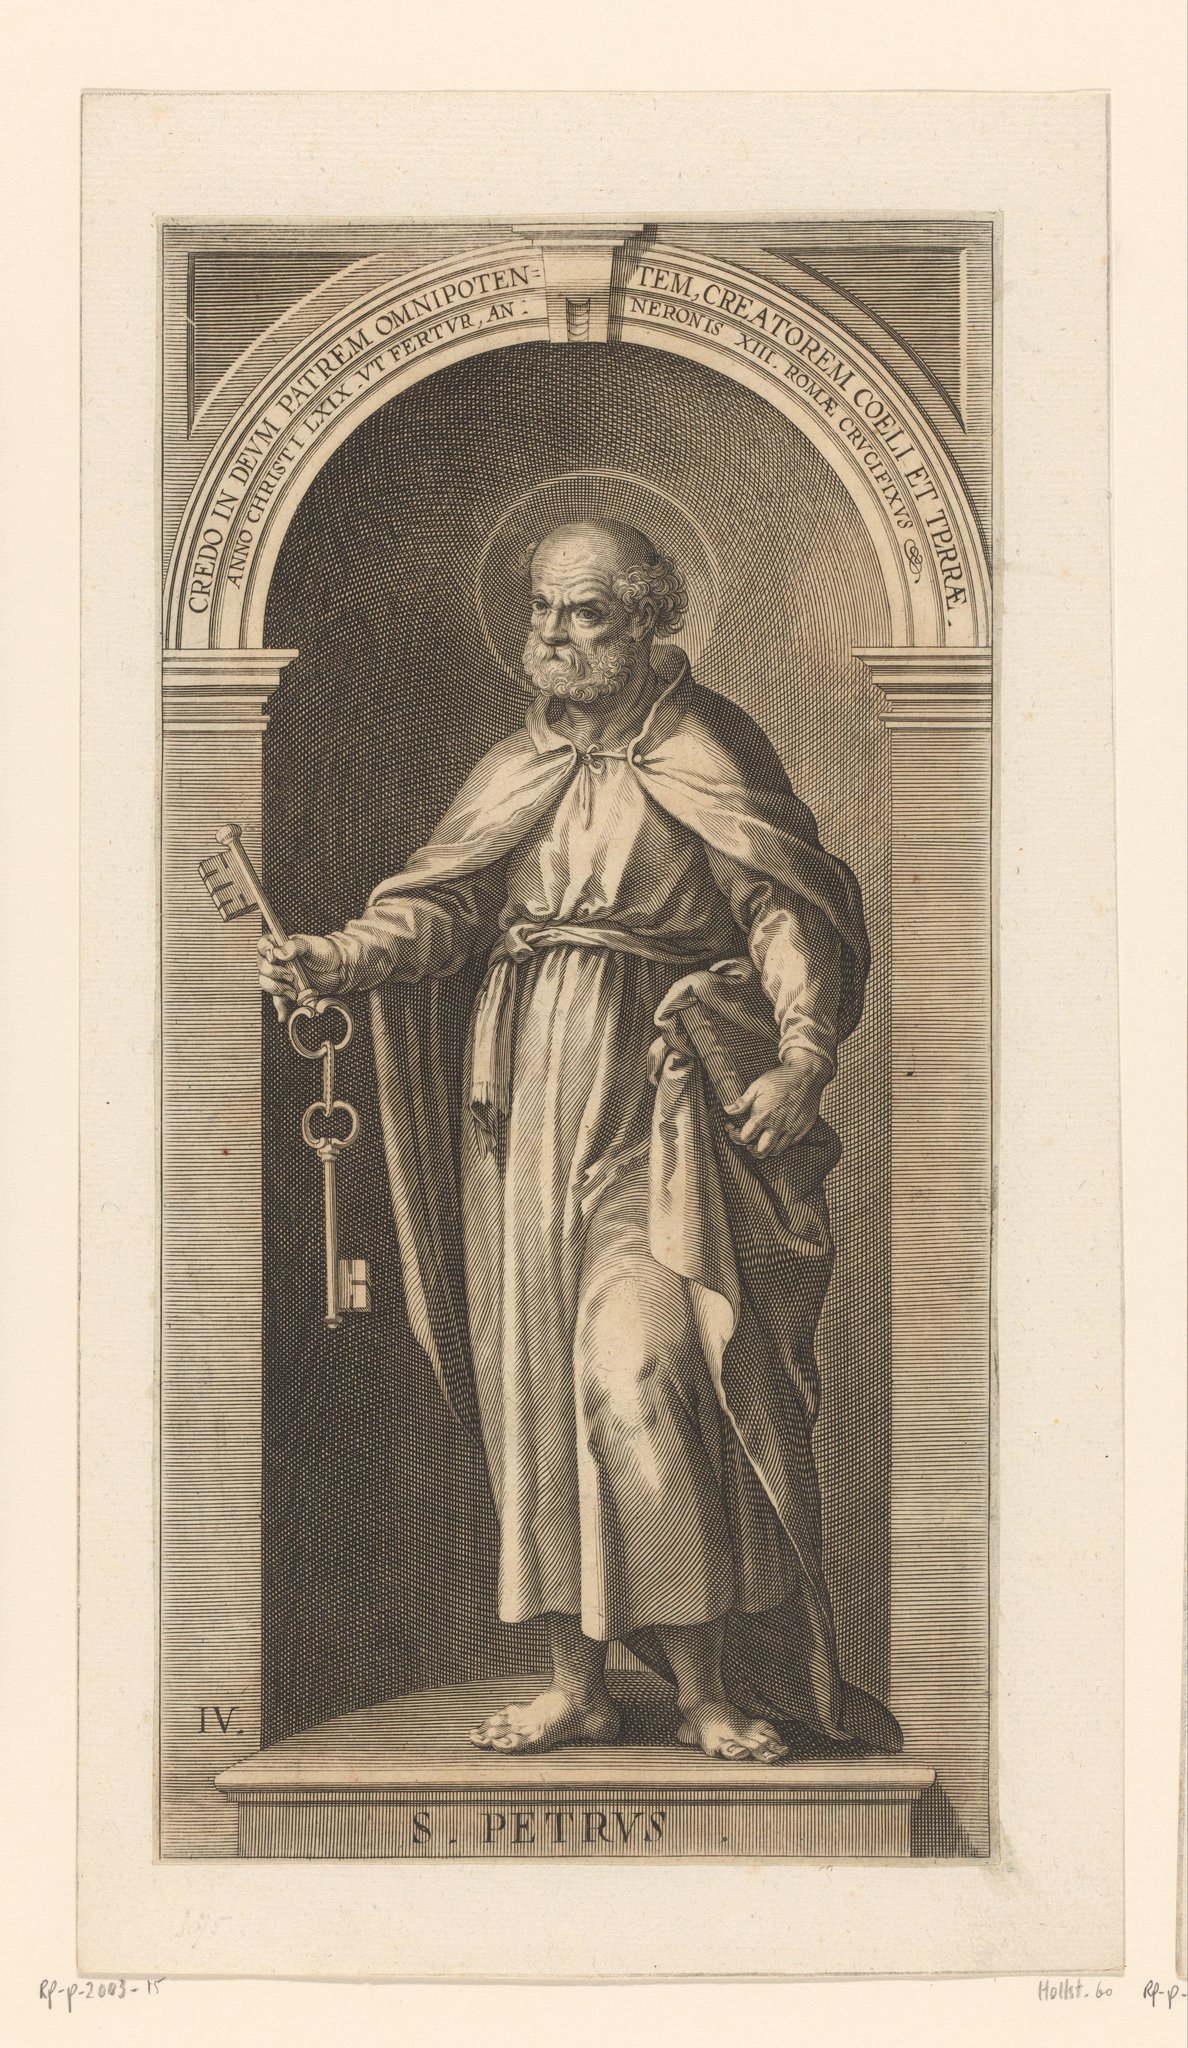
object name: print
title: Christelijk Heiligdom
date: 1623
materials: paper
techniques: engraving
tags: the apostle peter, first bishop of rome; possible attributes: book, cock, (upturned) cross, (triple) crozier, fish, key, scroll, ship, tiara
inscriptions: collector's mark: Lugt 2760, collector's mark: Lugt 2228, collector's mark: Lugt 567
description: Tekst uit Bijbelpassage in het Latijn in de bogen van de nis.